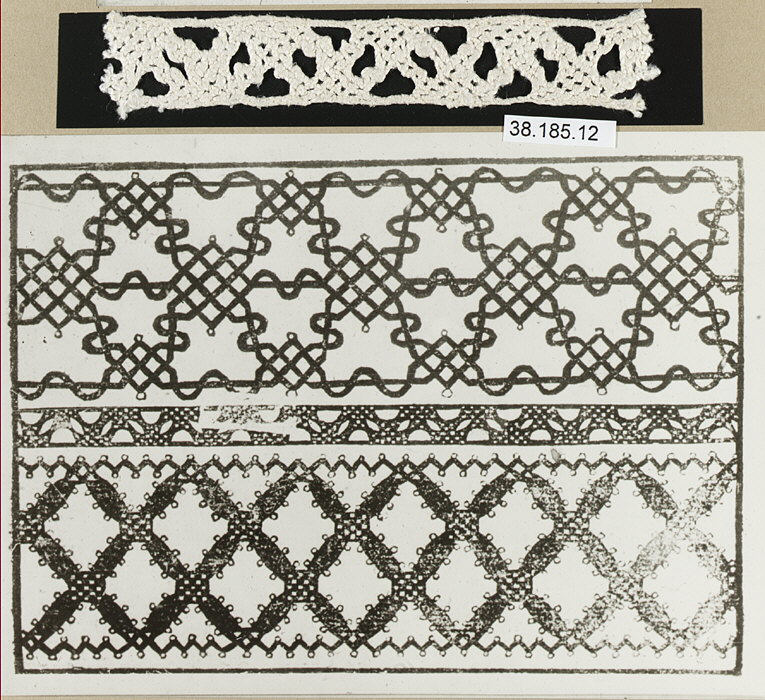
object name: insertion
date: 1501-1600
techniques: lace